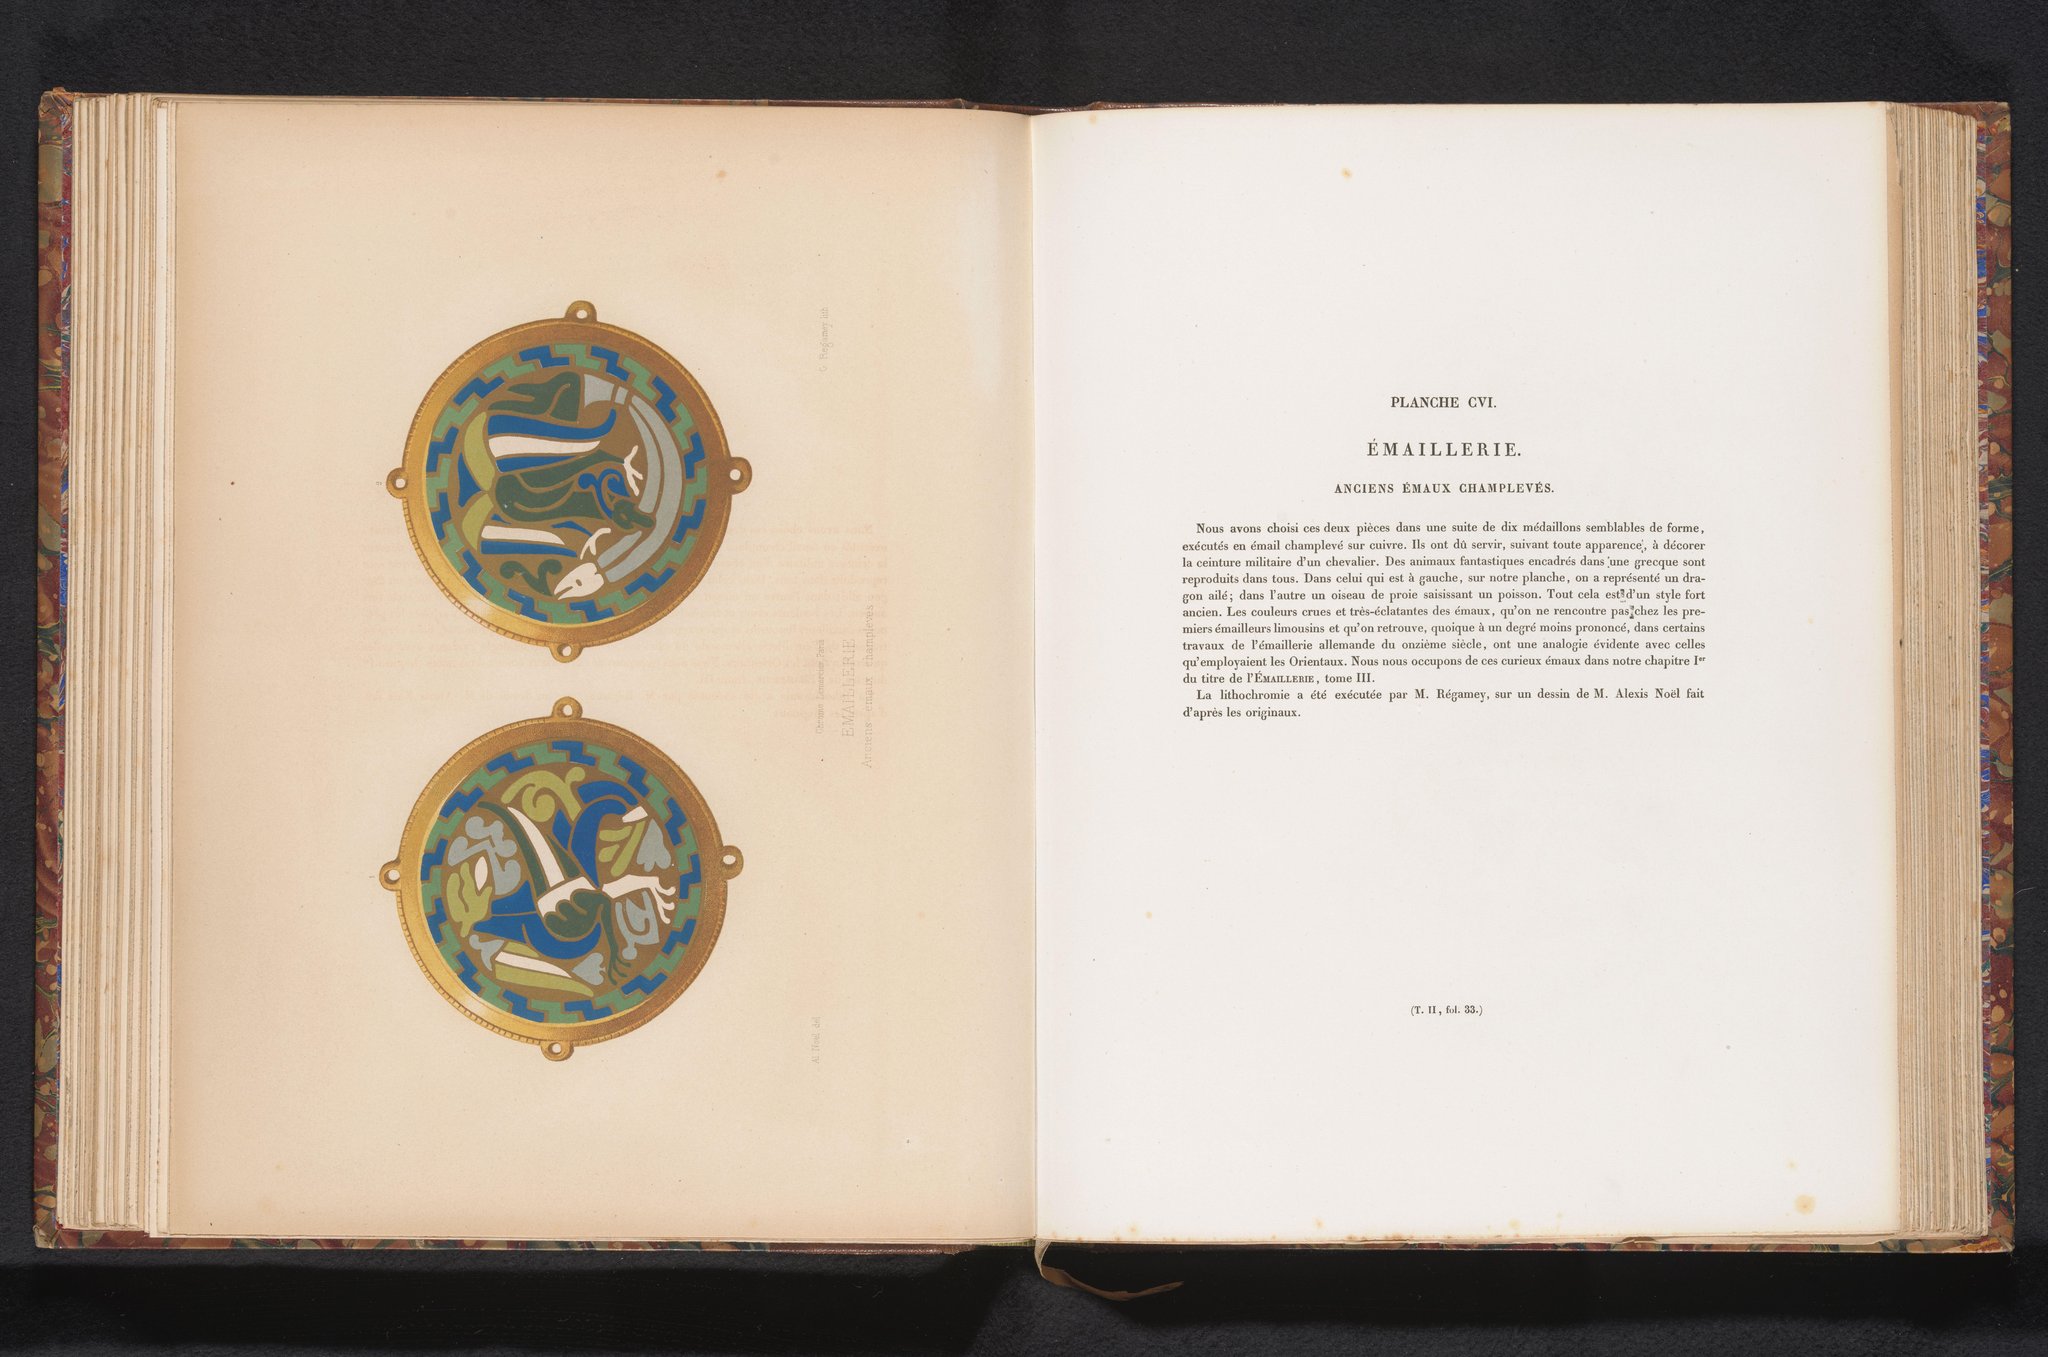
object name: reproduction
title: Anciens emaux champleves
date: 1859-1864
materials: paper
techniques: chromolithography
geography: paris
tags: ornament ~ medallion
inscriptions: name: ‘Al. Noël del/ G. Regamey lith.’